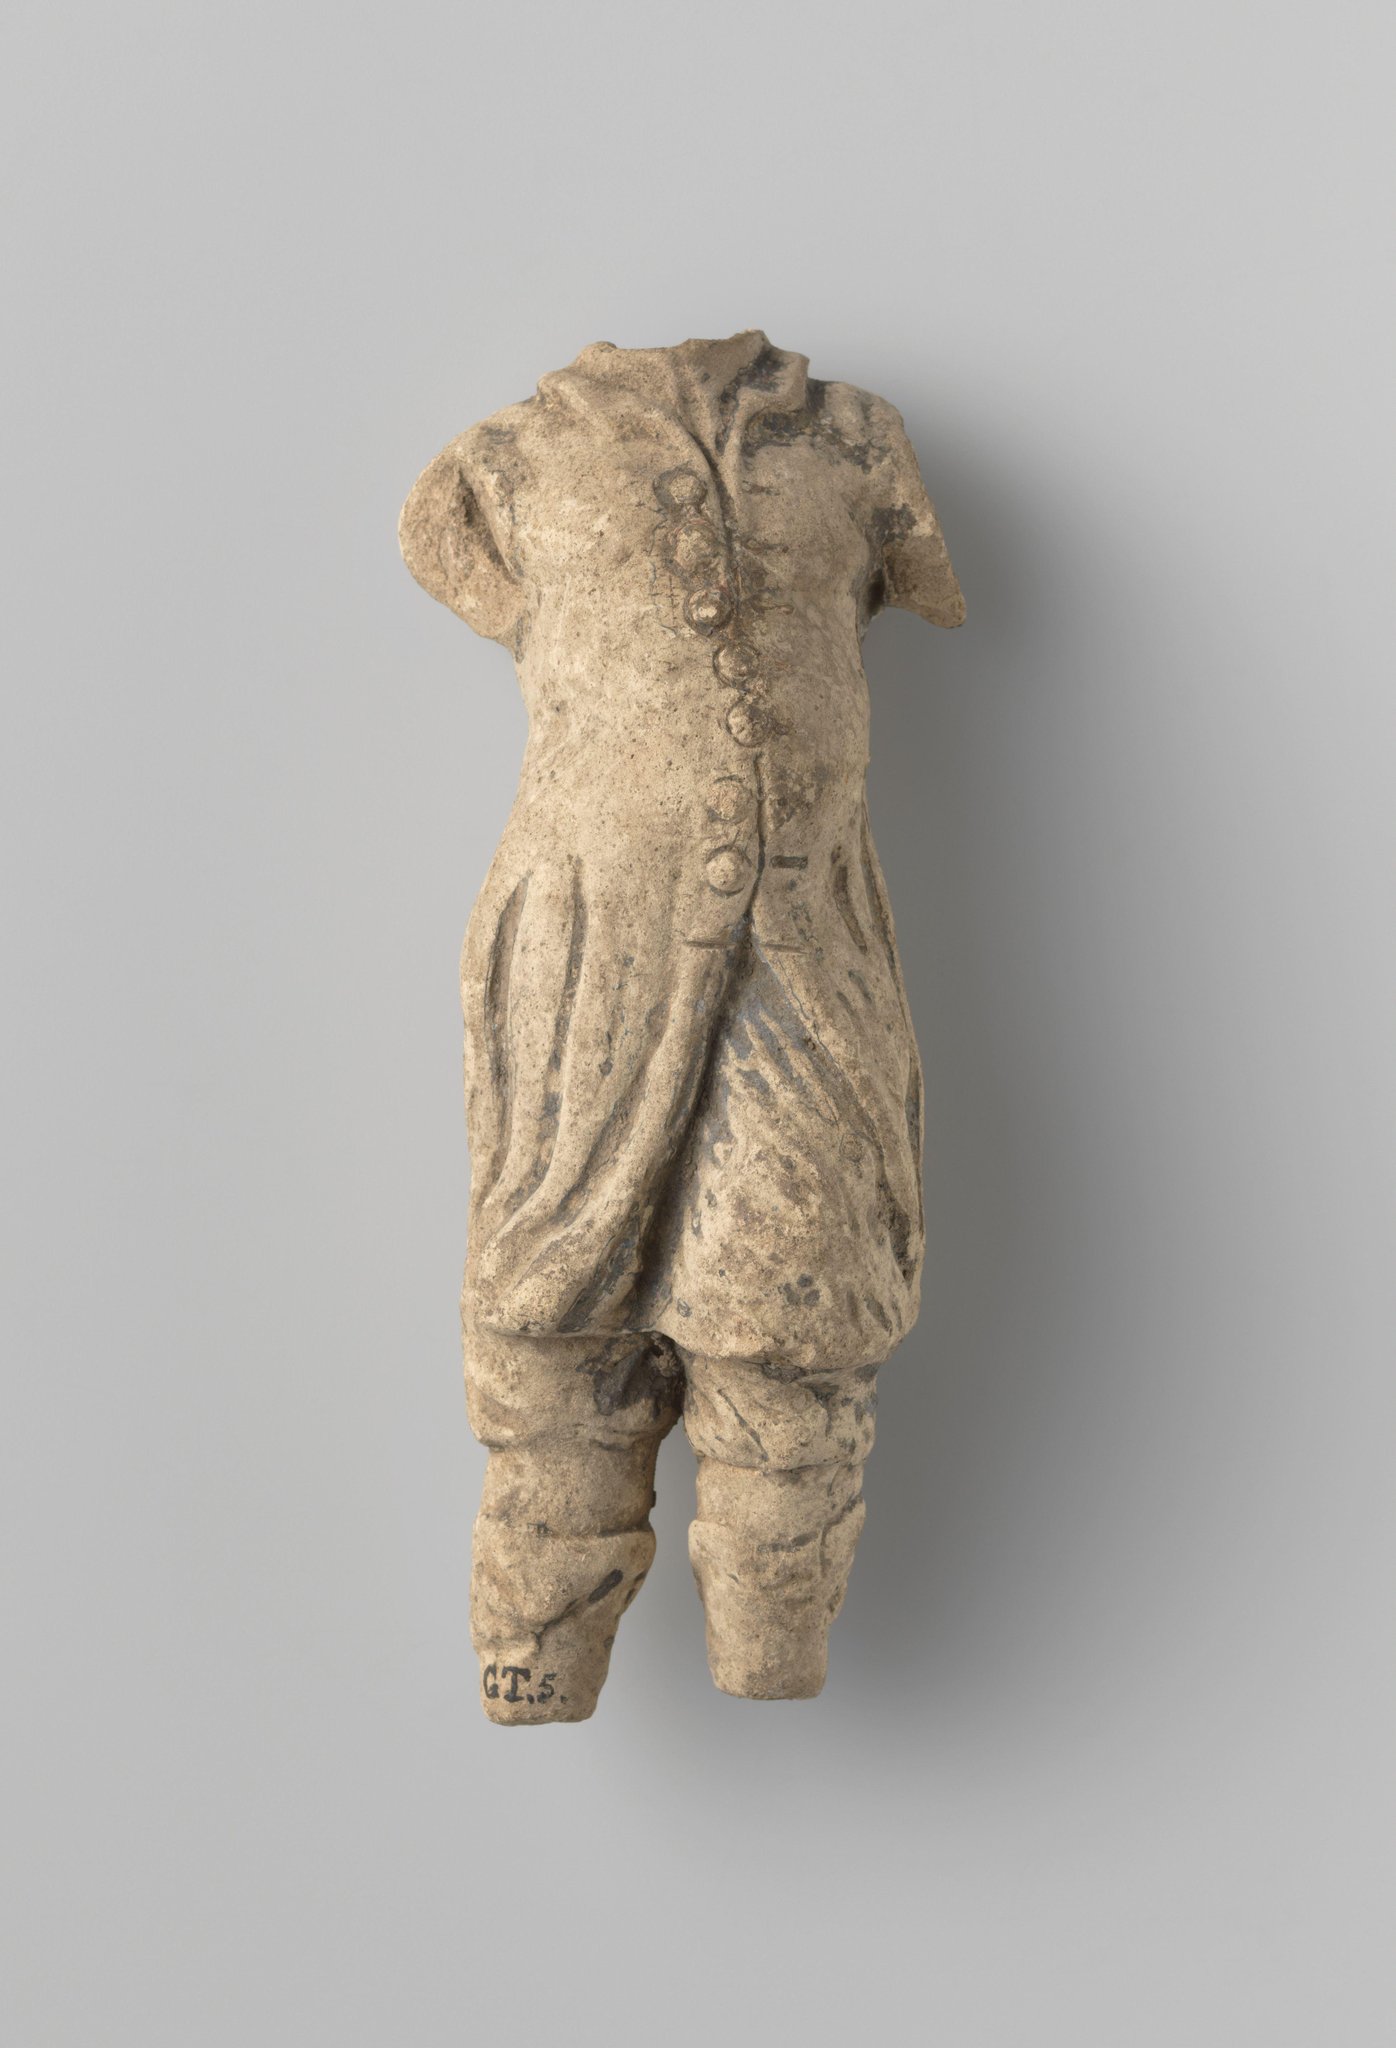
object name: fragment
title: Fragment van een beeldhouwwerk.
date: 1875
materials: clay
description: Middelste gedeelte van een mansbeeld, met lange dichtgeknoopte jas, korte broek en hoge laarzen.